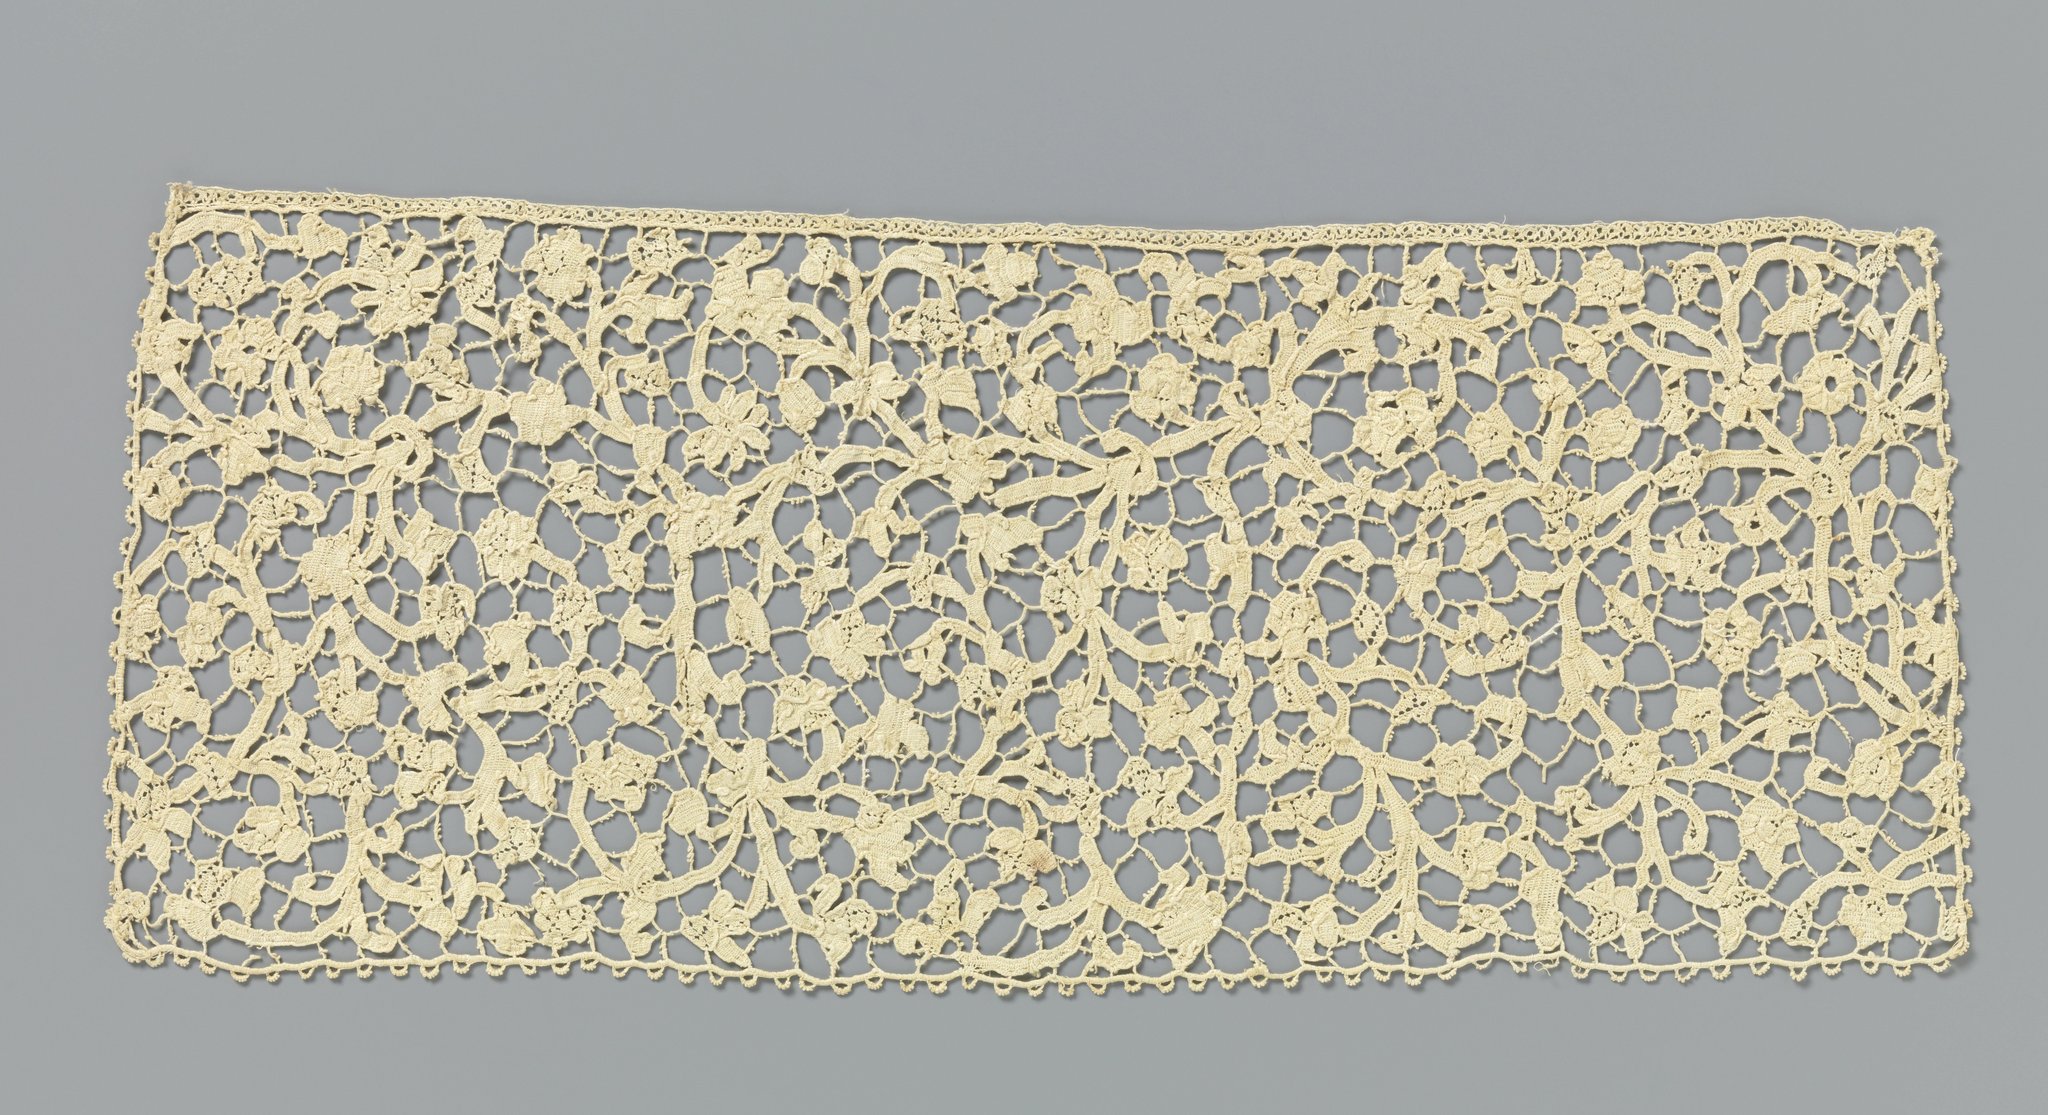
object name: clothing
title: Dasslip van naaldkant met symmetrisch patroon van vele ranken met kleine bladeren en bloemen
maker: Anonymous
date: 1675-1699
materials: linen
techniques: flat venetian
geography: venice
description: Dasslip van naturelkleurige naaldkant: platte Venetiaanse kant. Ogenschijnlijk warrig doch symmetrisch patroon met een vertikale as in het midden van waaruit zich vele omkrullende bloem- en bladranken bewegen. De motieven zijn gemaakt met festonsteken, waarbij met uitsparingen eenvoudige patroontjes in verschillende bloemen en bladeren zijn gerealiseerd. De motieven zijn met elkaar verbonden door een gepicoteerde spijlengrond. De bovenzijde van de strook is afgewerkt met een geklost bandje. De onderzijde en twee korte zijden zijn afgewerkt met een boogjesrandje.